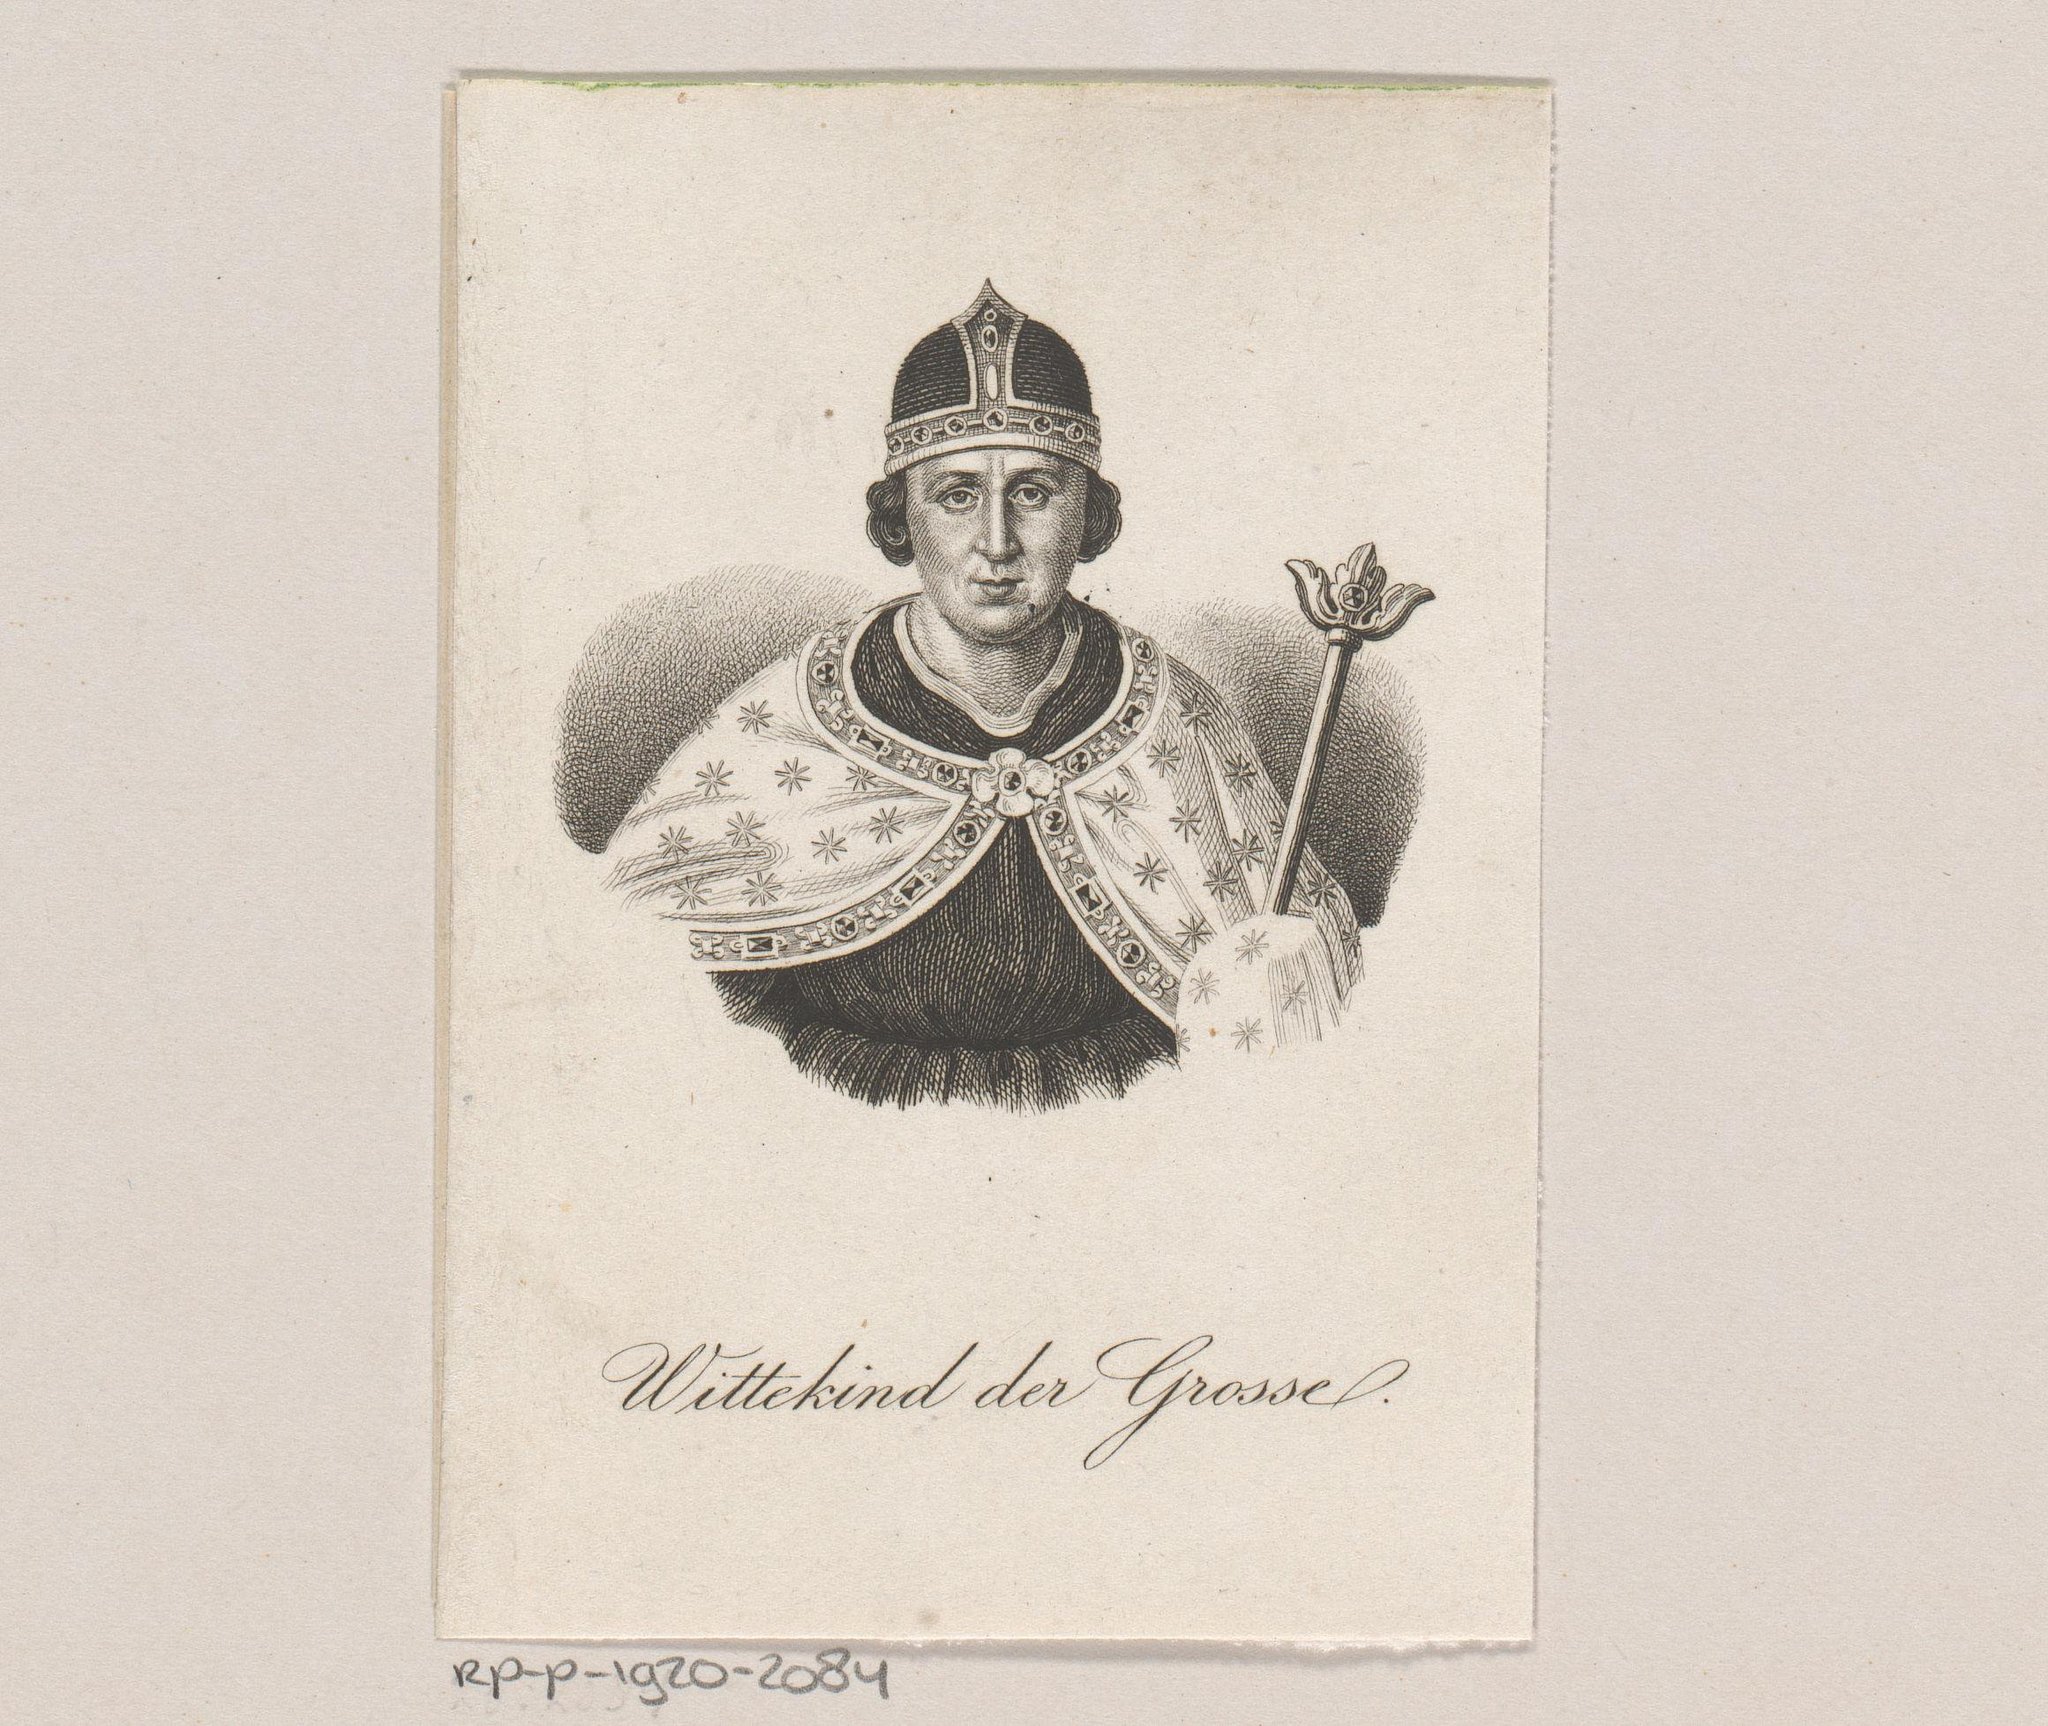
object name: print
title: Portret van Widukind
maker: Anonymous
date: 1820-1899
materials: paper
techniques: etching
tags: crown (symbol of sovereignty), sceptre, staff (symbol of sovereignty), historical persons, mantle, gown, dress (symbol of sovereignty)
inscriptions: collector's mark: Lugt 2228